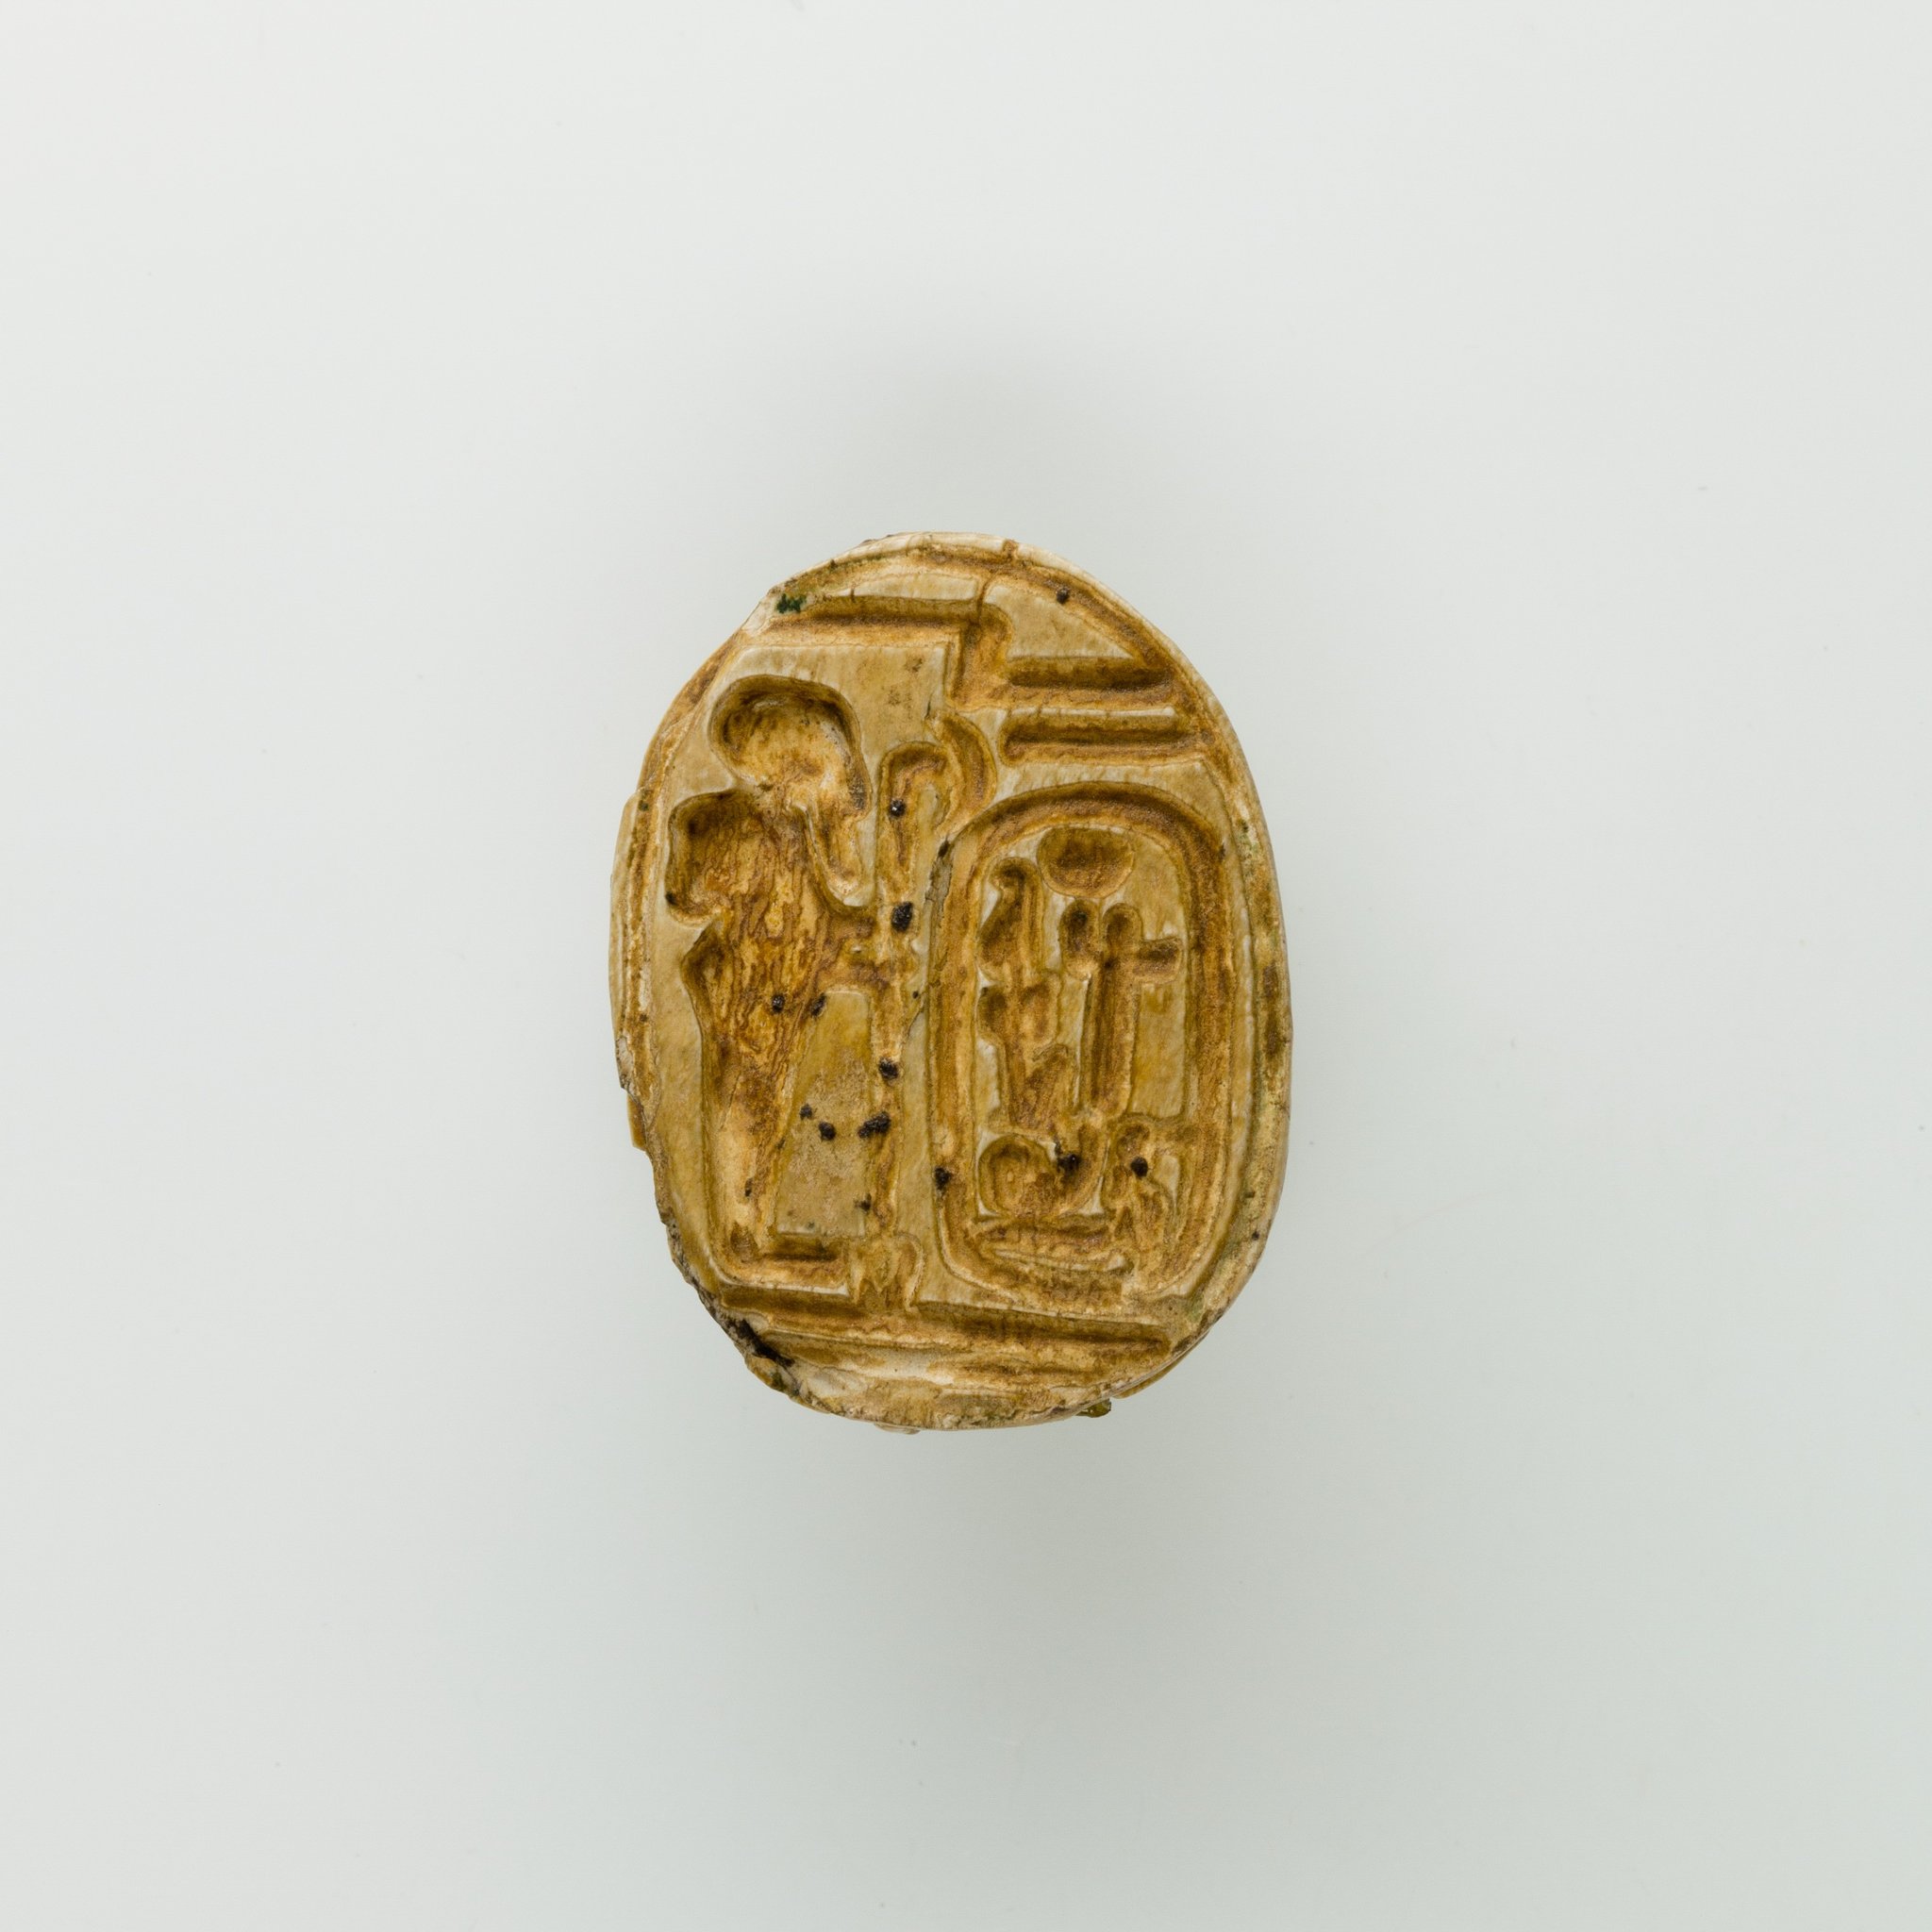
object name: scarab, ramesses ii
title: Scarab of Ramesses II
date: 1295-1070 BCE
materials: stone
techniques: glazing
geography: egypt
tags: scarabs